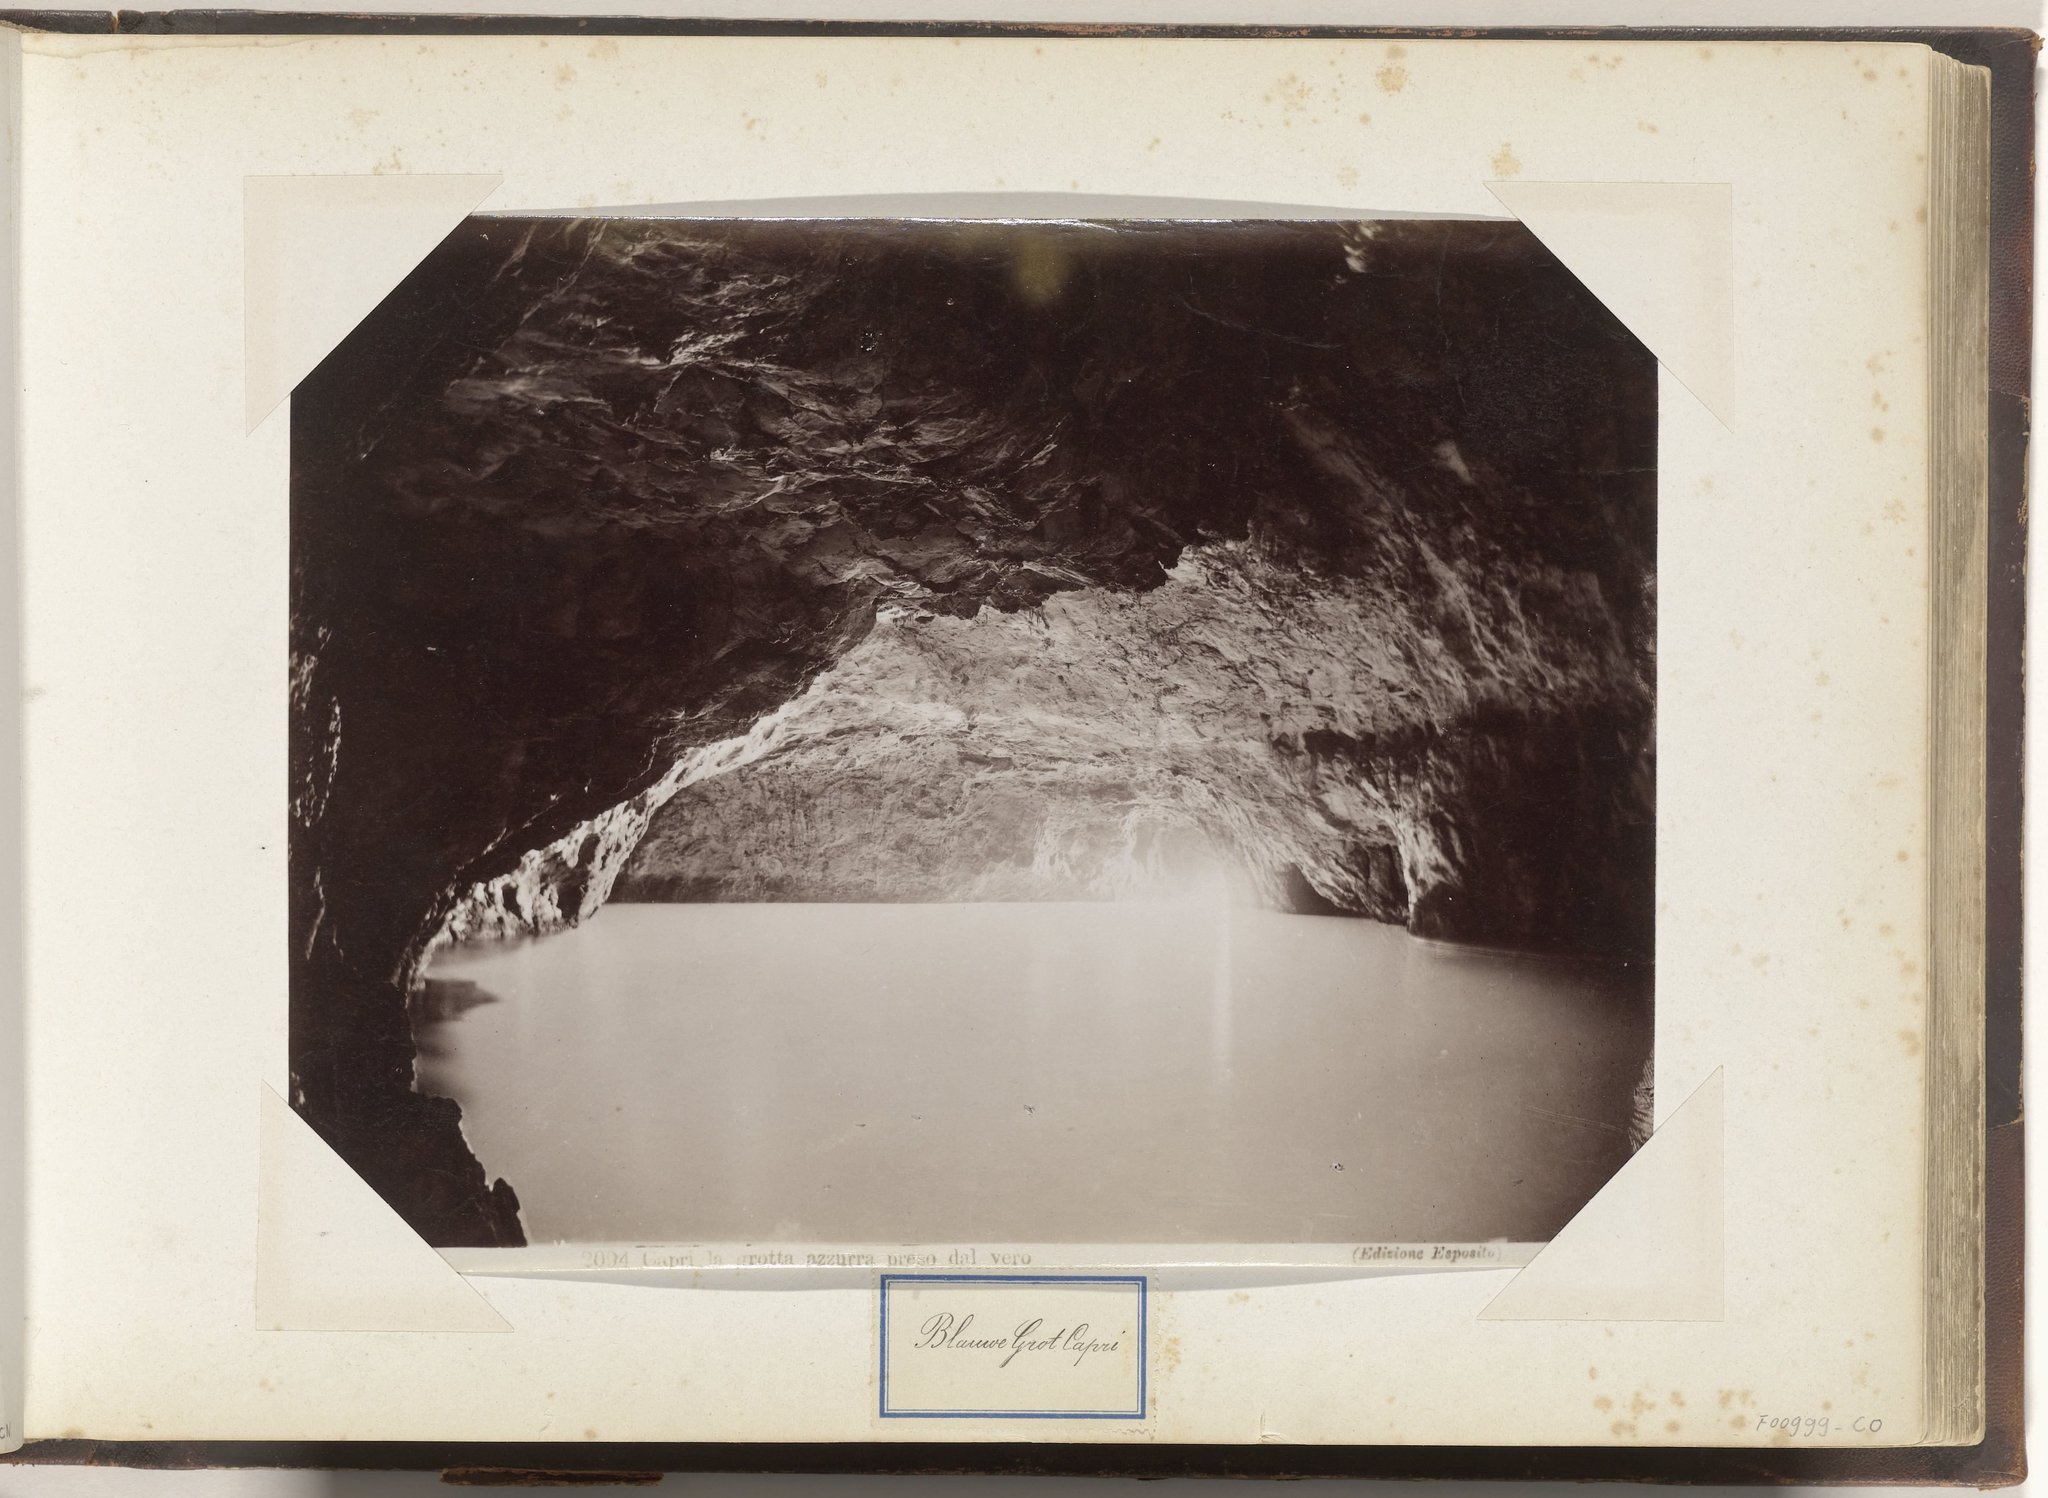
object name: photograph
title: Interieur van de Blauwe grot op Capri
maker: Anonymous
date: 1880-1920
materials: paper, photographic support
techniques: albumen print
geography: capri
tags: cave, grotto, capri, isola di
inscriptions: negative number: ‘2094’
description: Onderdeel van Album met 191 foto's van een reis naar en door Zuid-Afrika.